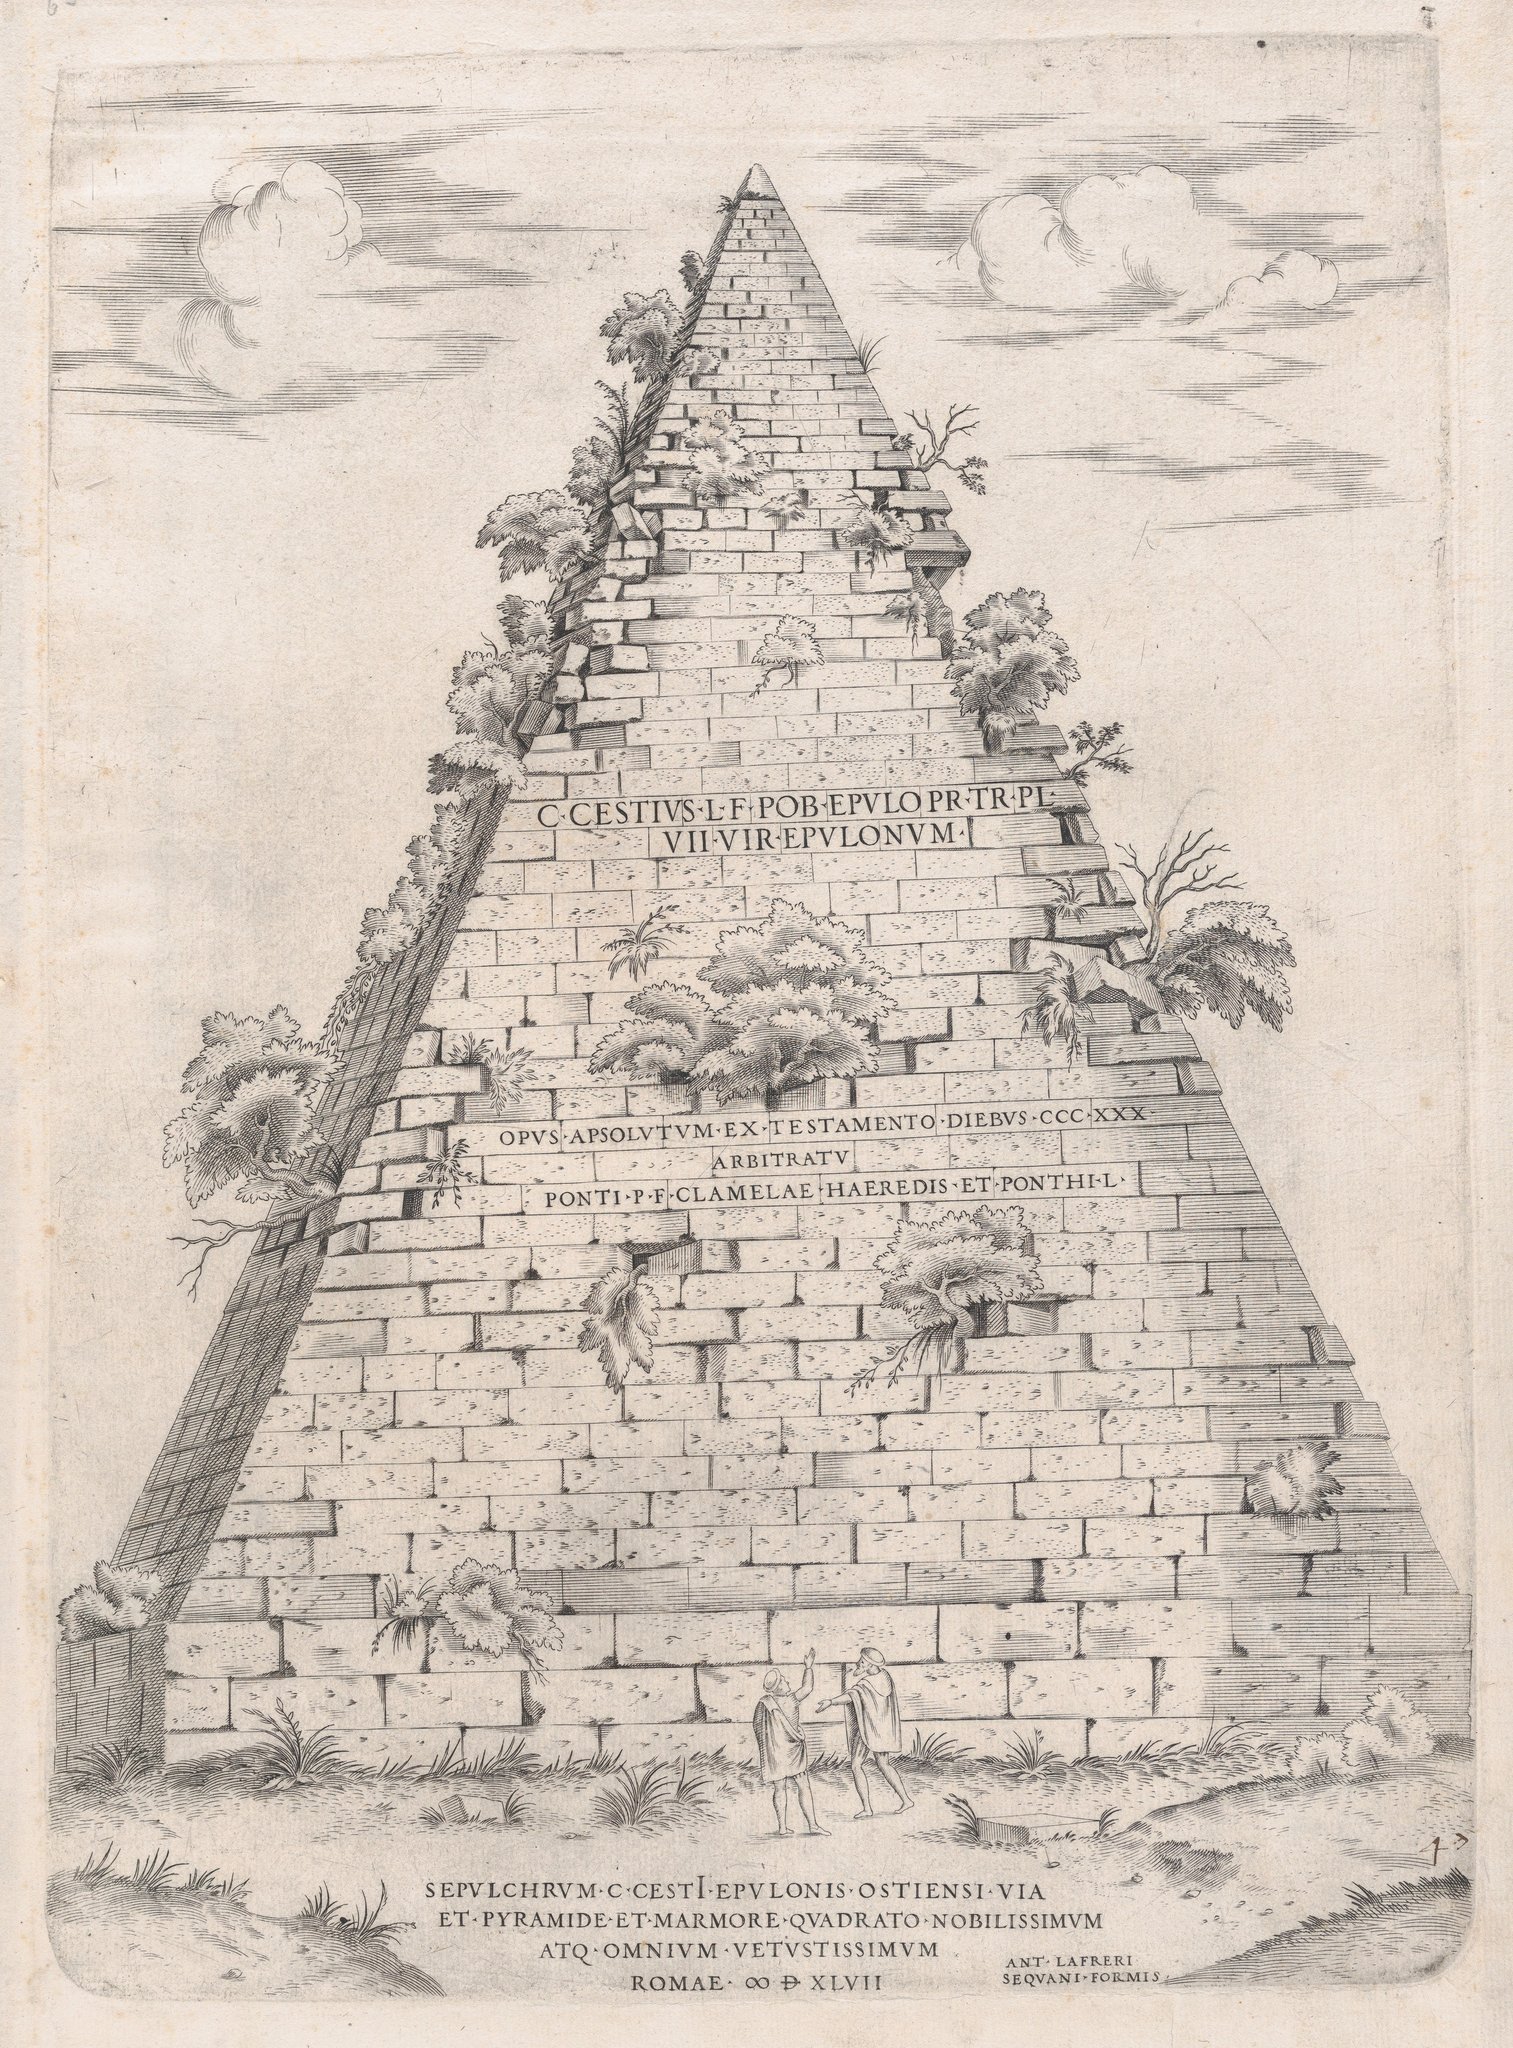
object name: print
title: Pyramid of Caius Cestius, from "Speculum Romanae Magnificentiae"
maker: Anonymous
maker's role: artist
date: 1547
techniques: engraving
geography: rome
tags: tombs,rome